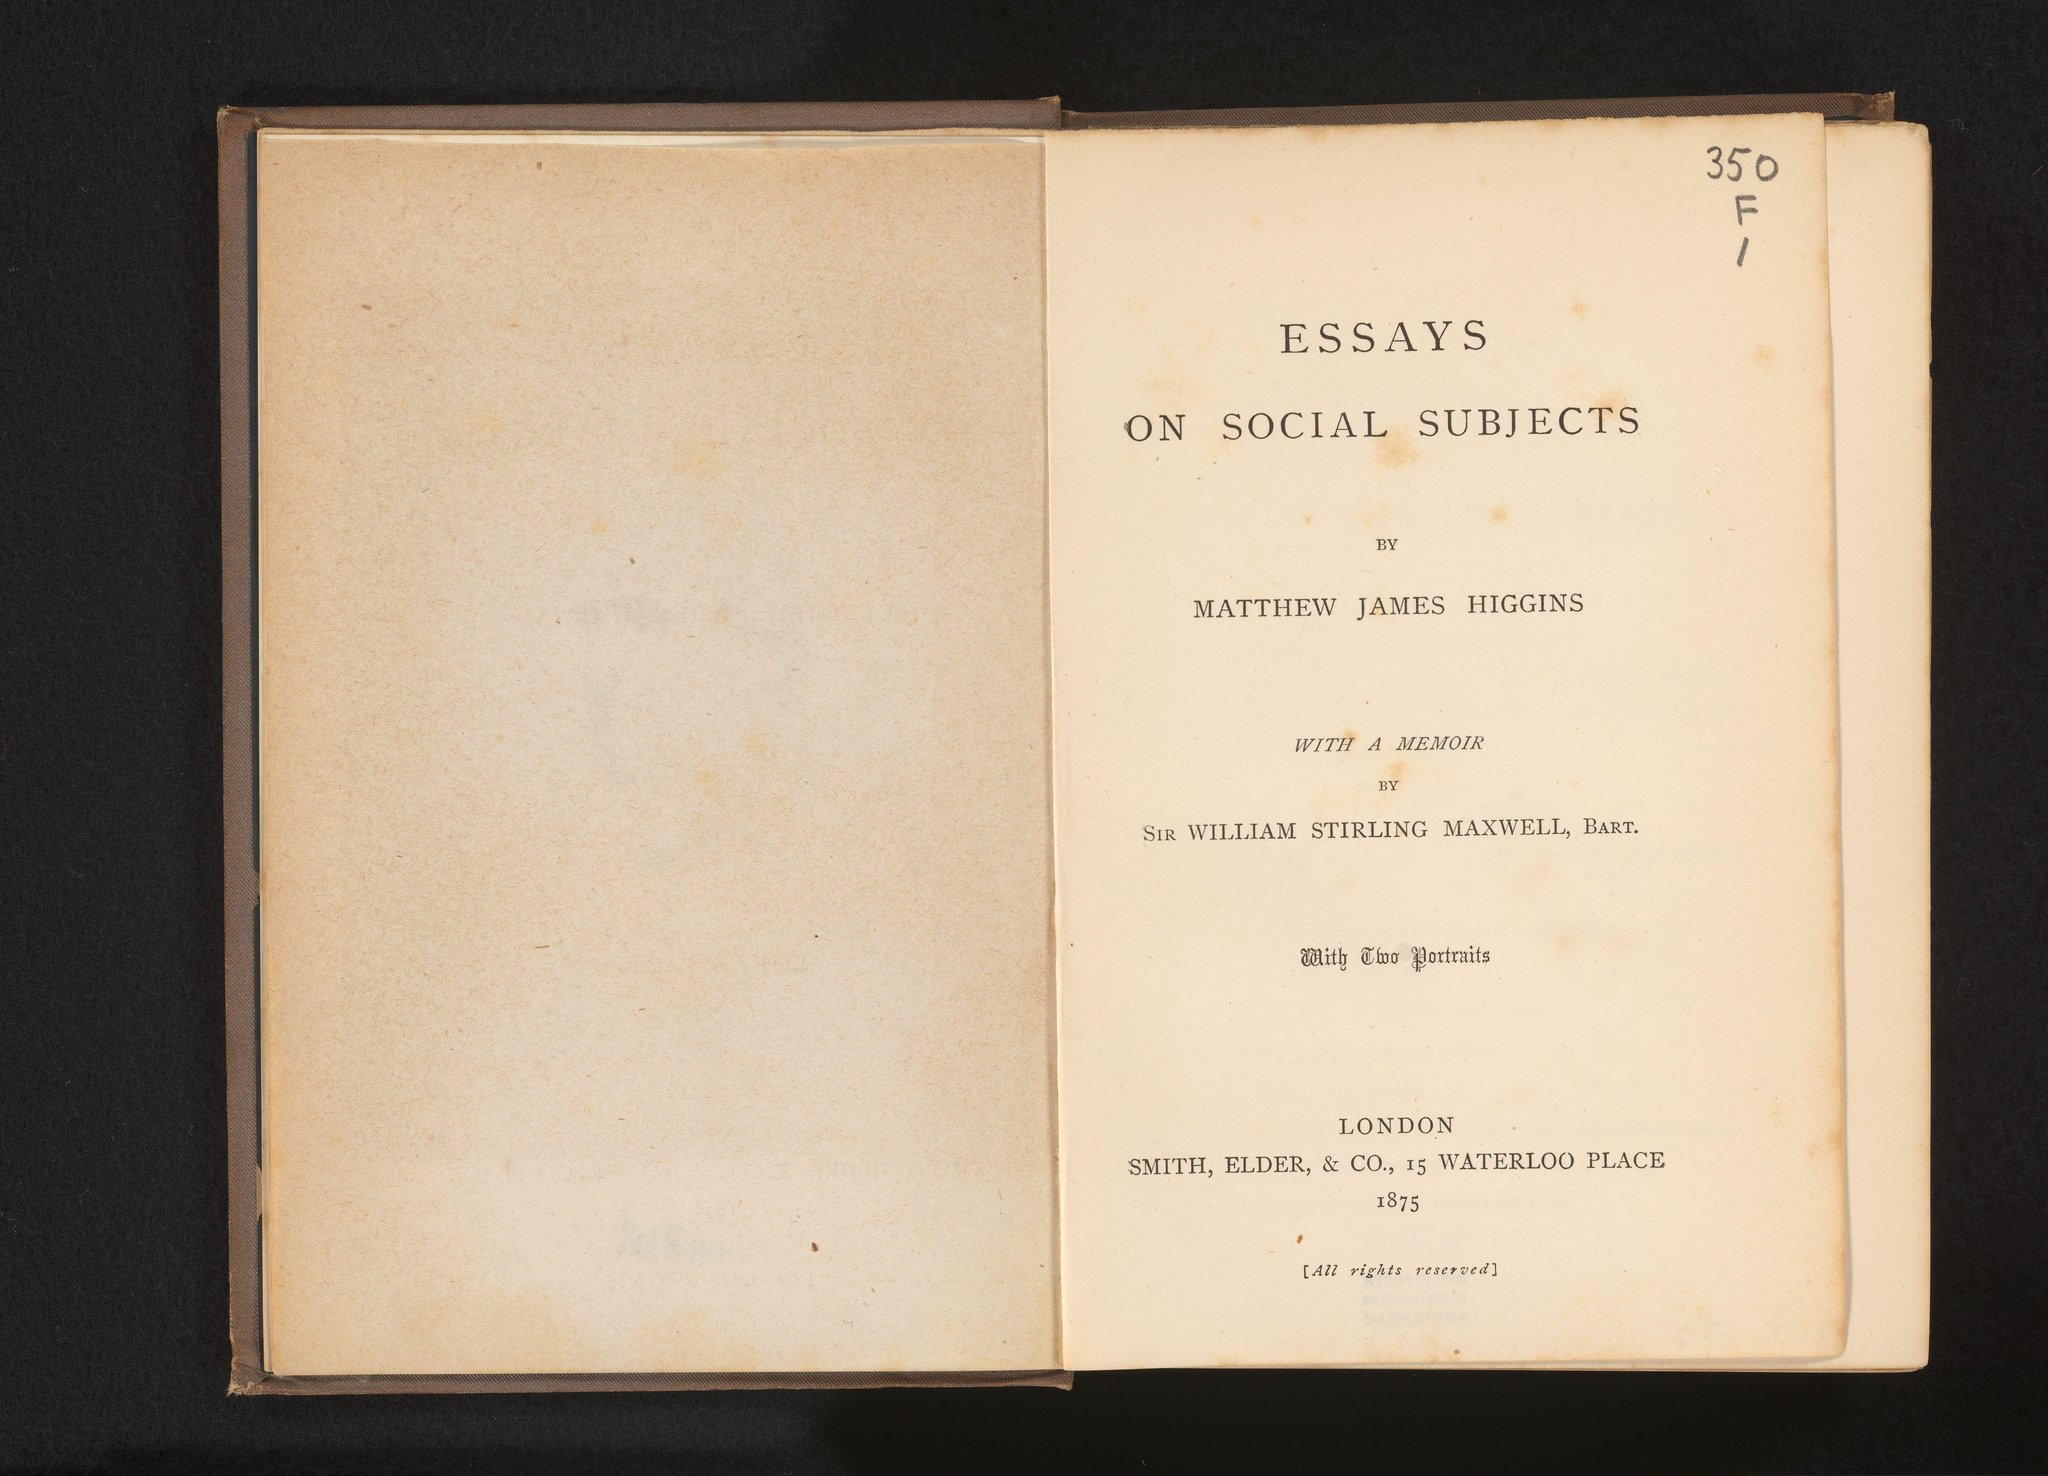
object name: book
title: Essays on social subjects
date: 1875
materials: cardboard, paper, linen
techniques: albumen print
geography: london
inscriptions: inscription: ‘BOUND BY/ BURN/ & CO’